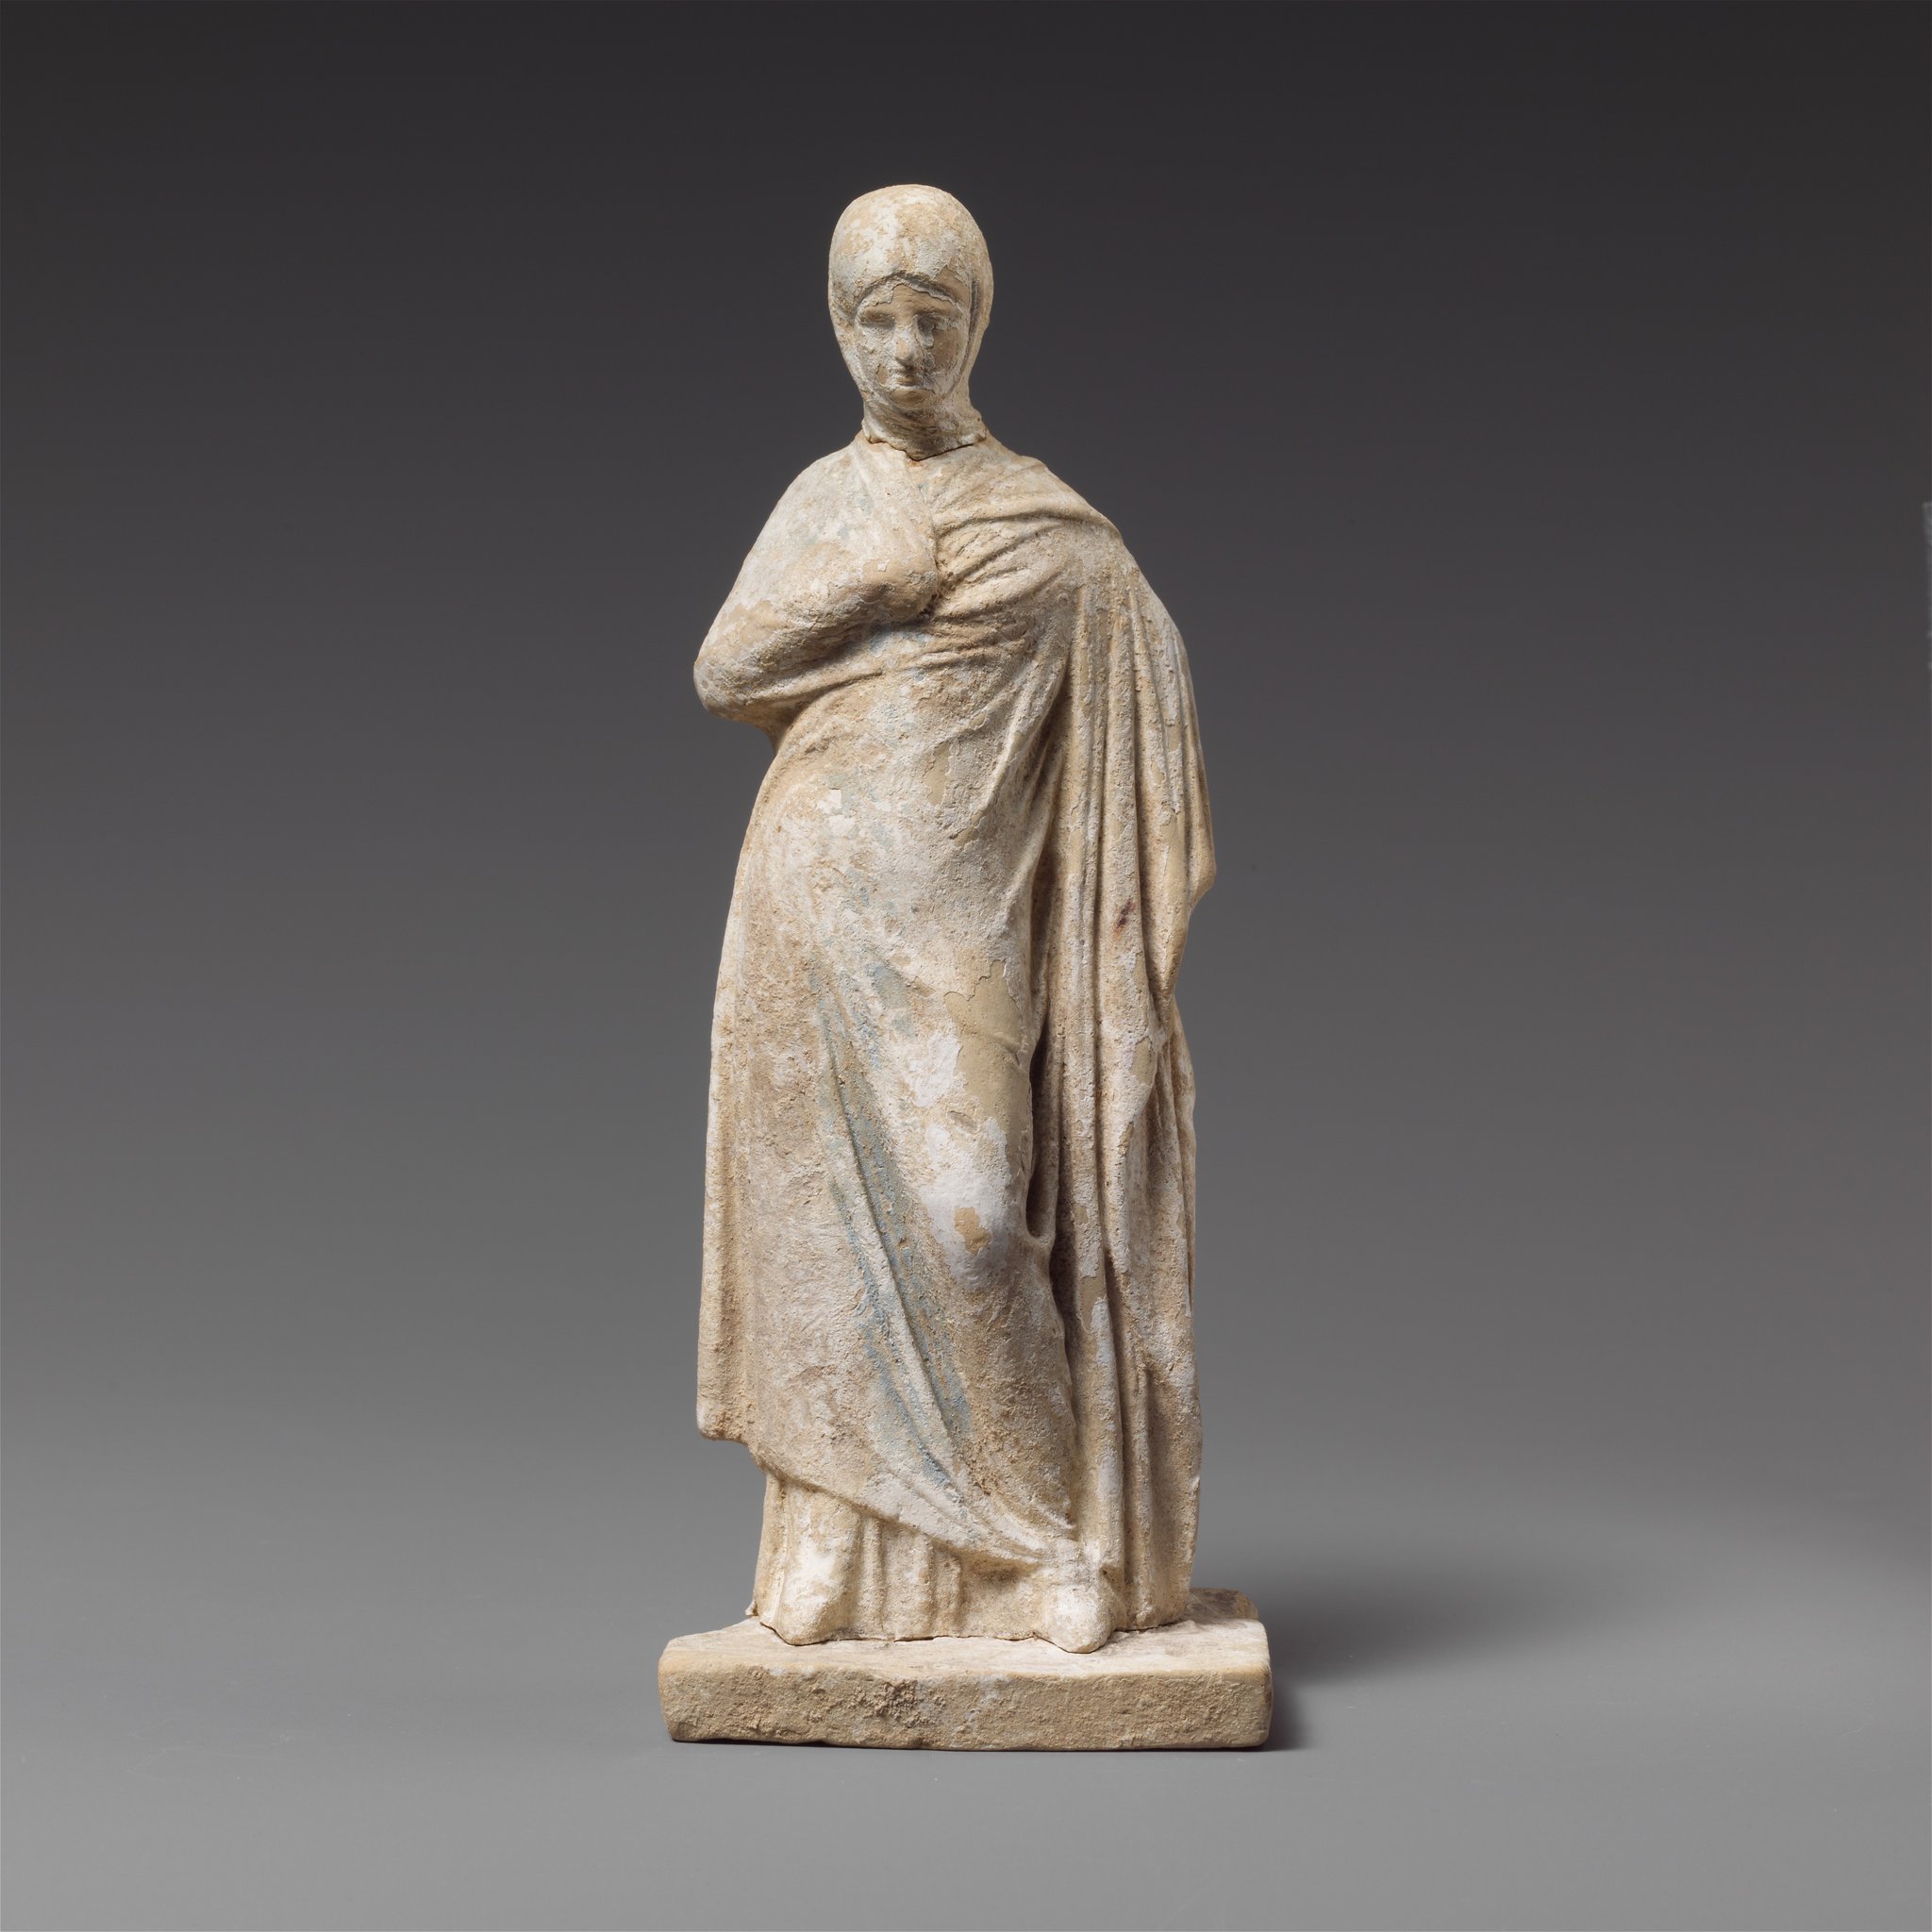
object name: statuette of a woman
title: Terracotta statuette of a draped woman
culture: greek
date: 334-301 BCE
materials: terracotta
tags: women